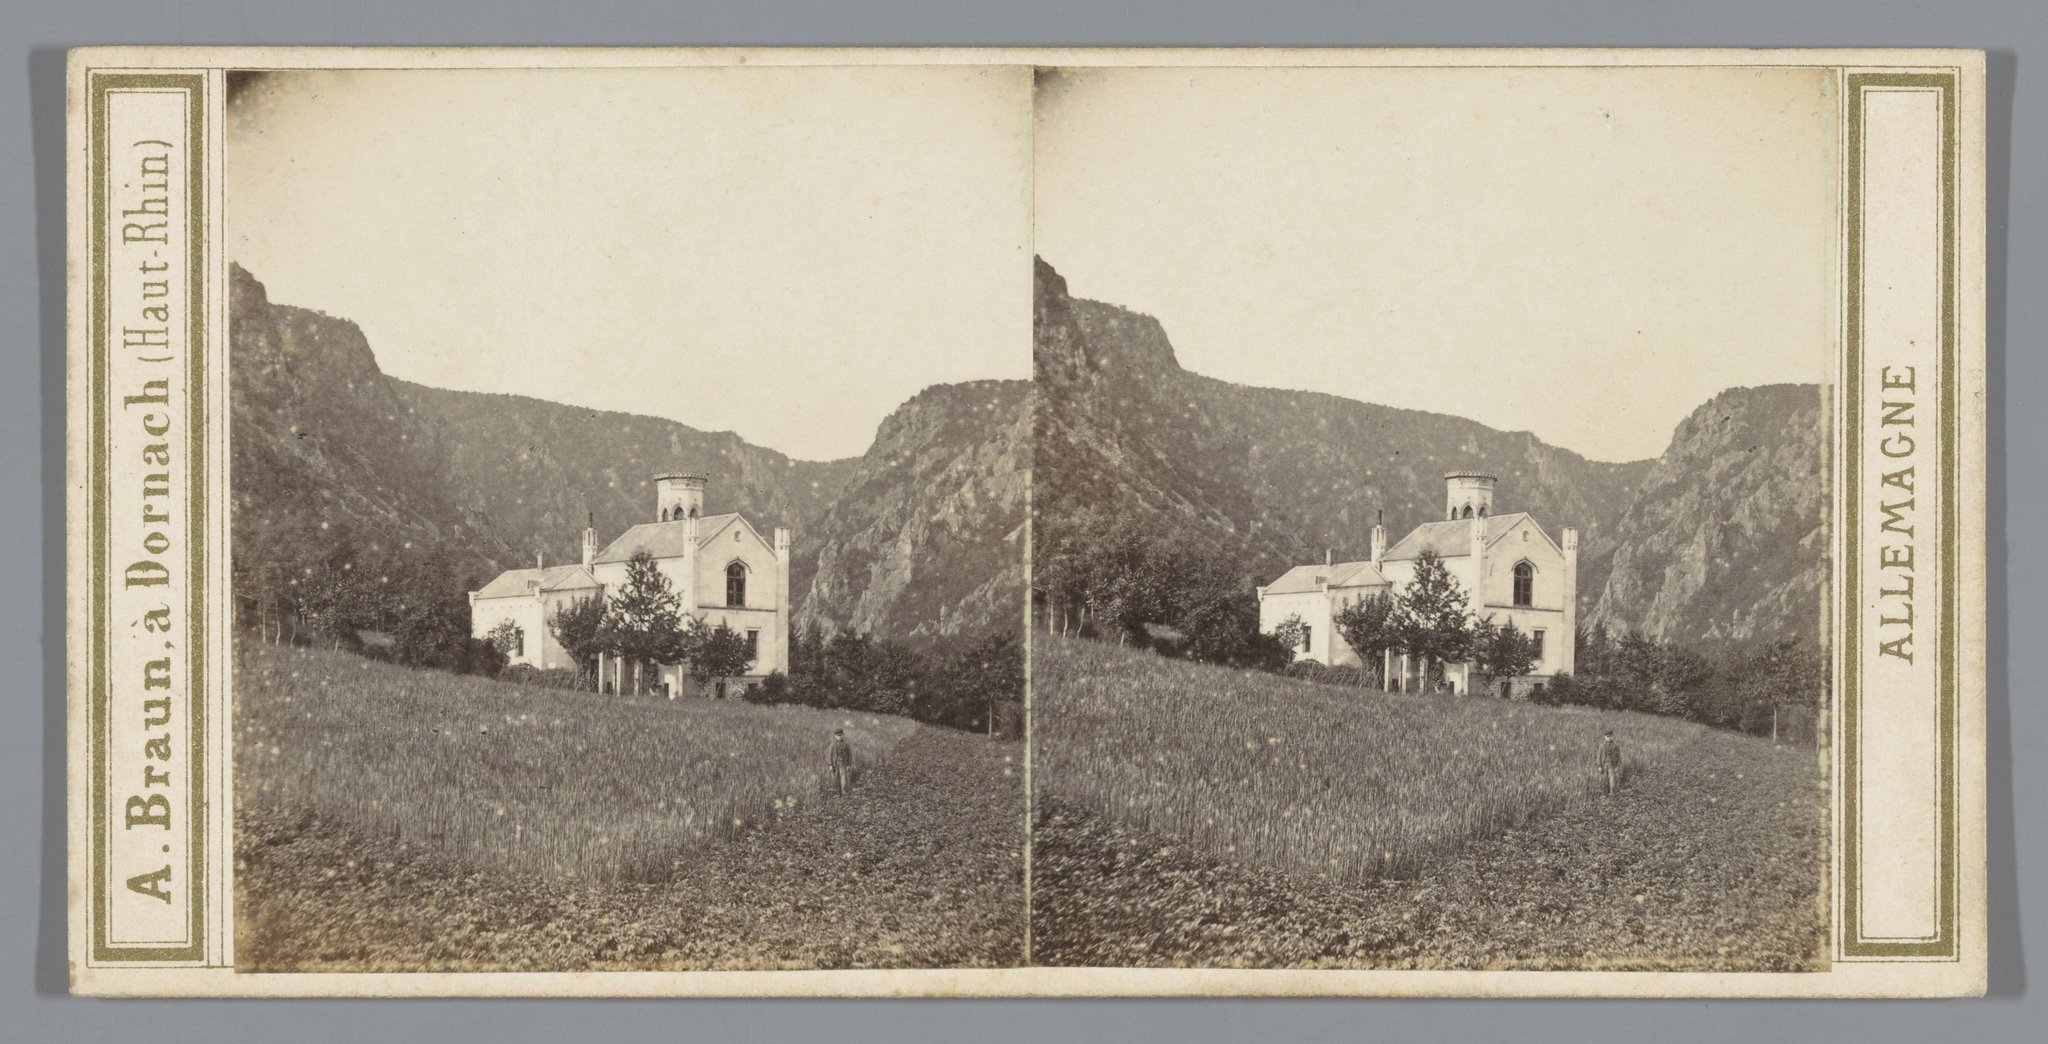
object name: stereograph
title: Harzgebirge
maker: Anonymous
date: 1860-1866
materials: cardboard, paper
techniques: albumen print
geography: hessen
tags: landscape with tower or castle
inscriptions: number: ‘No 2851.’